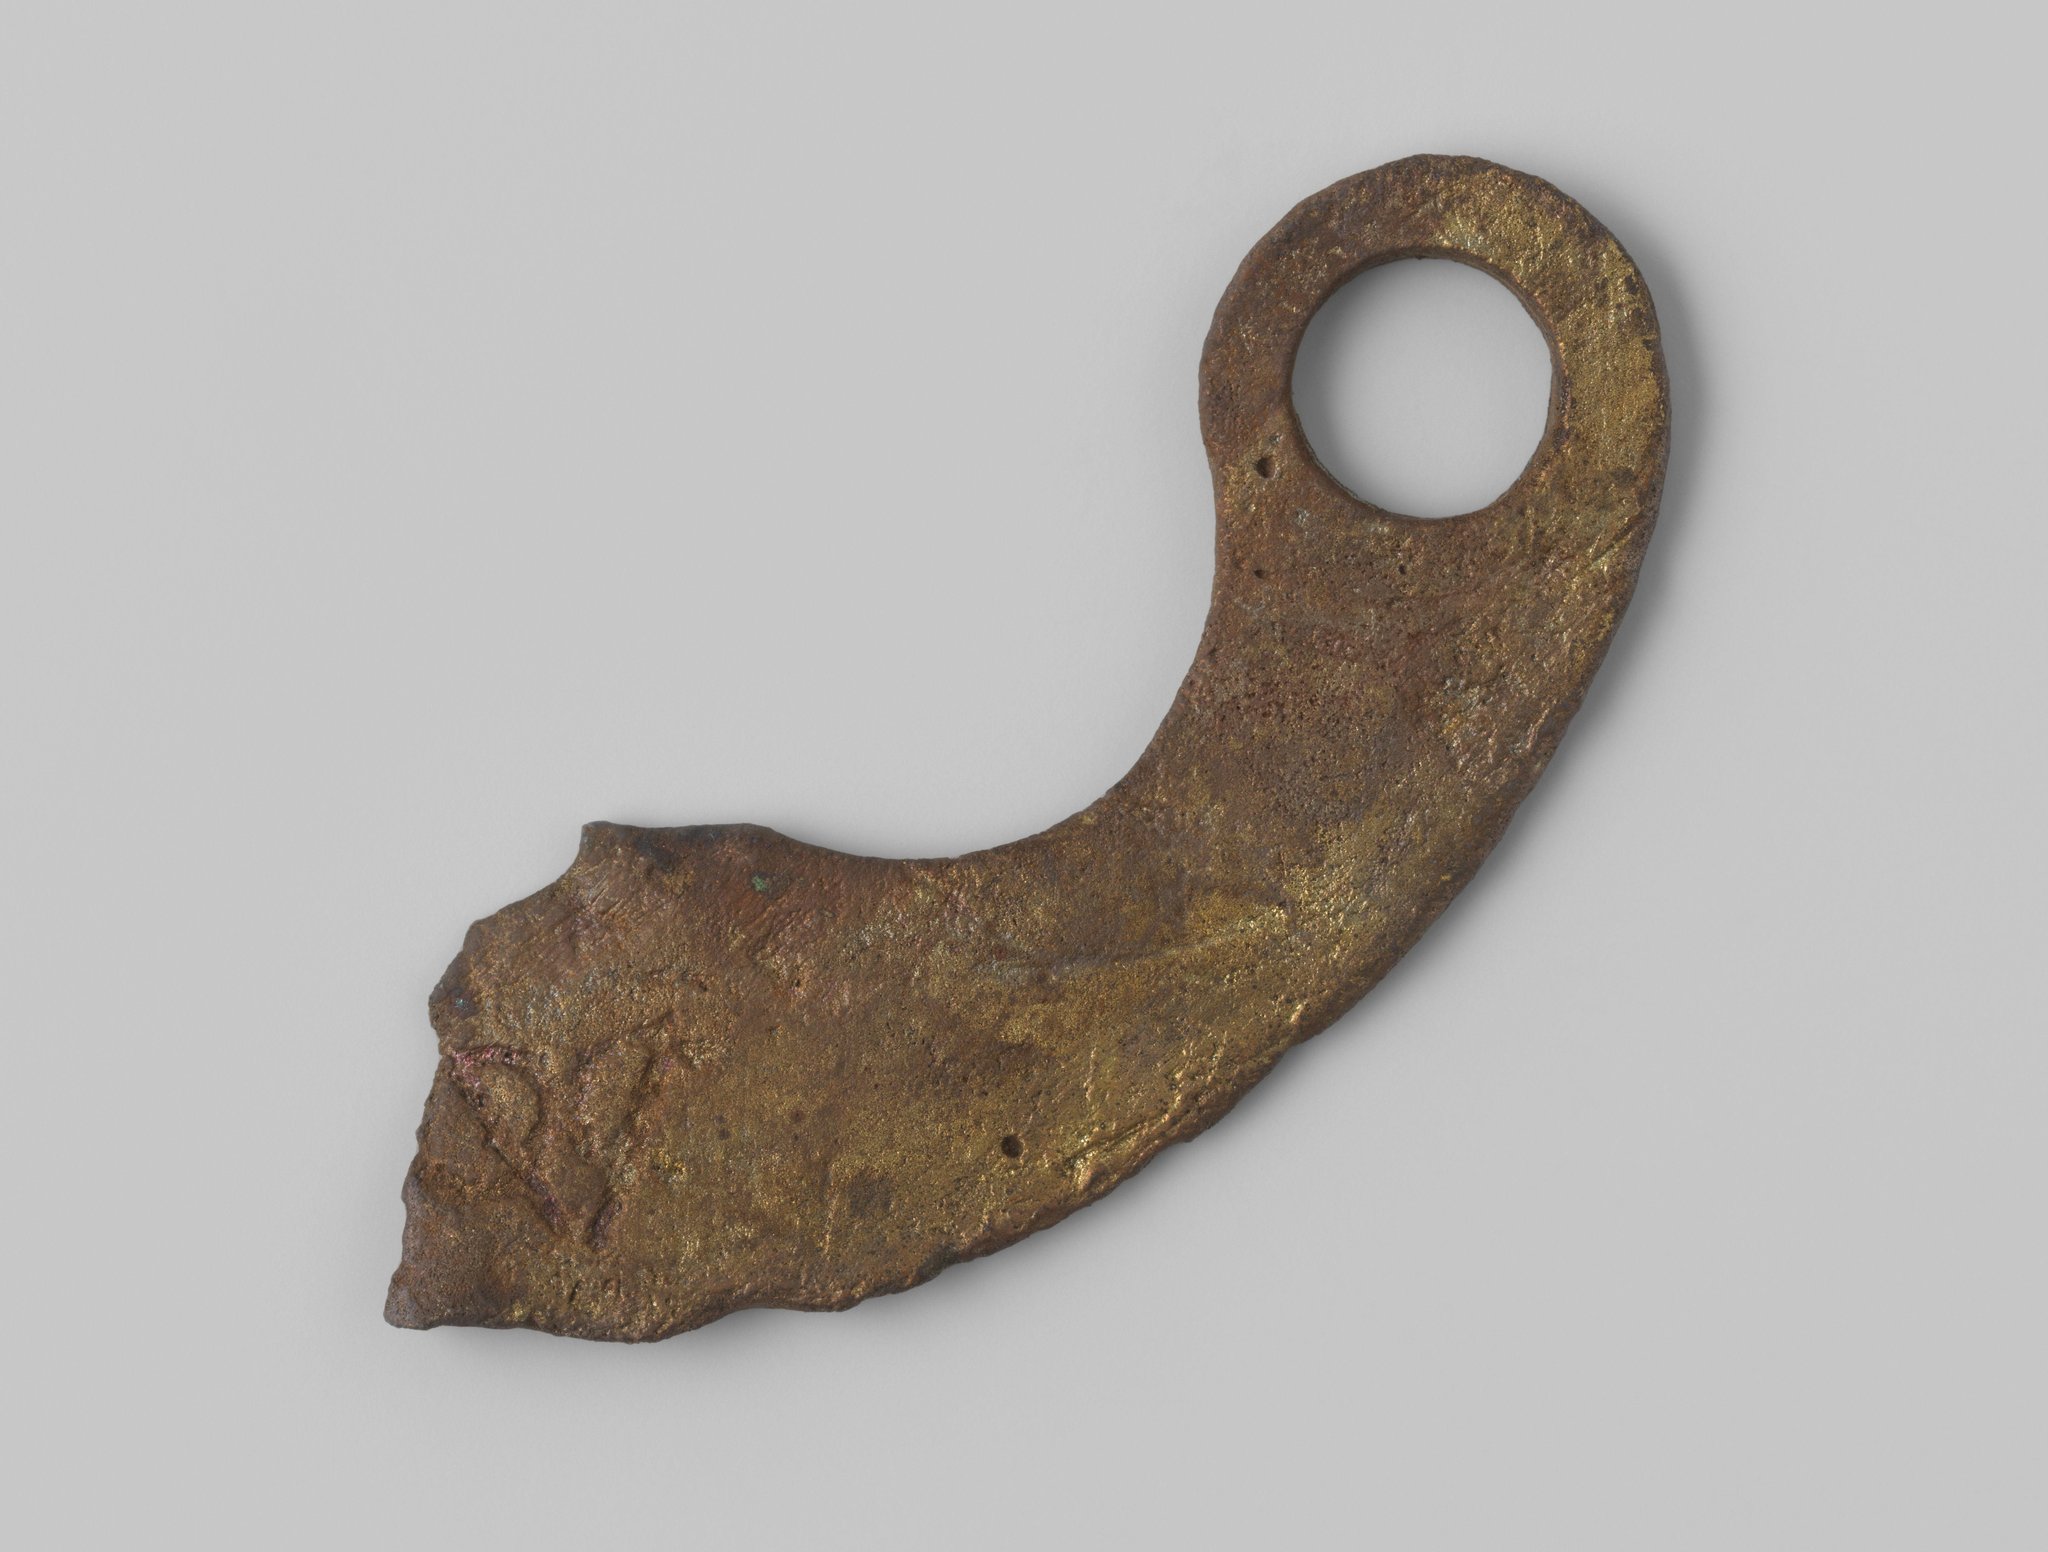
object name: schroefplaat, schroefblik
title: Fragment schroefplaat van een musket uit het wrak van de Oost-Indiëvaarder Hollandia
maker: Anonymous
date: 1700-1743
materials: copper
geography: netherlands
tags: verenigde oostindische compagnie, hollandia (schip), annet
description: Fragm right wing id. NG 1978-74H986 or NG 1980-27H3069, side plate.